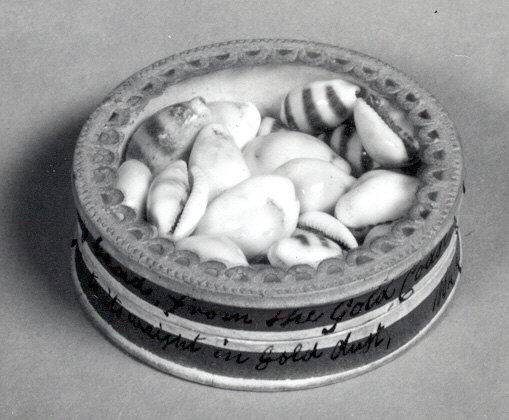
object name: box of cowrie shell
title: Box of Cowrie Shells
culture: ghanaian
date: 1801-1900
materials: cardboard, glass, shell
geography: ghana